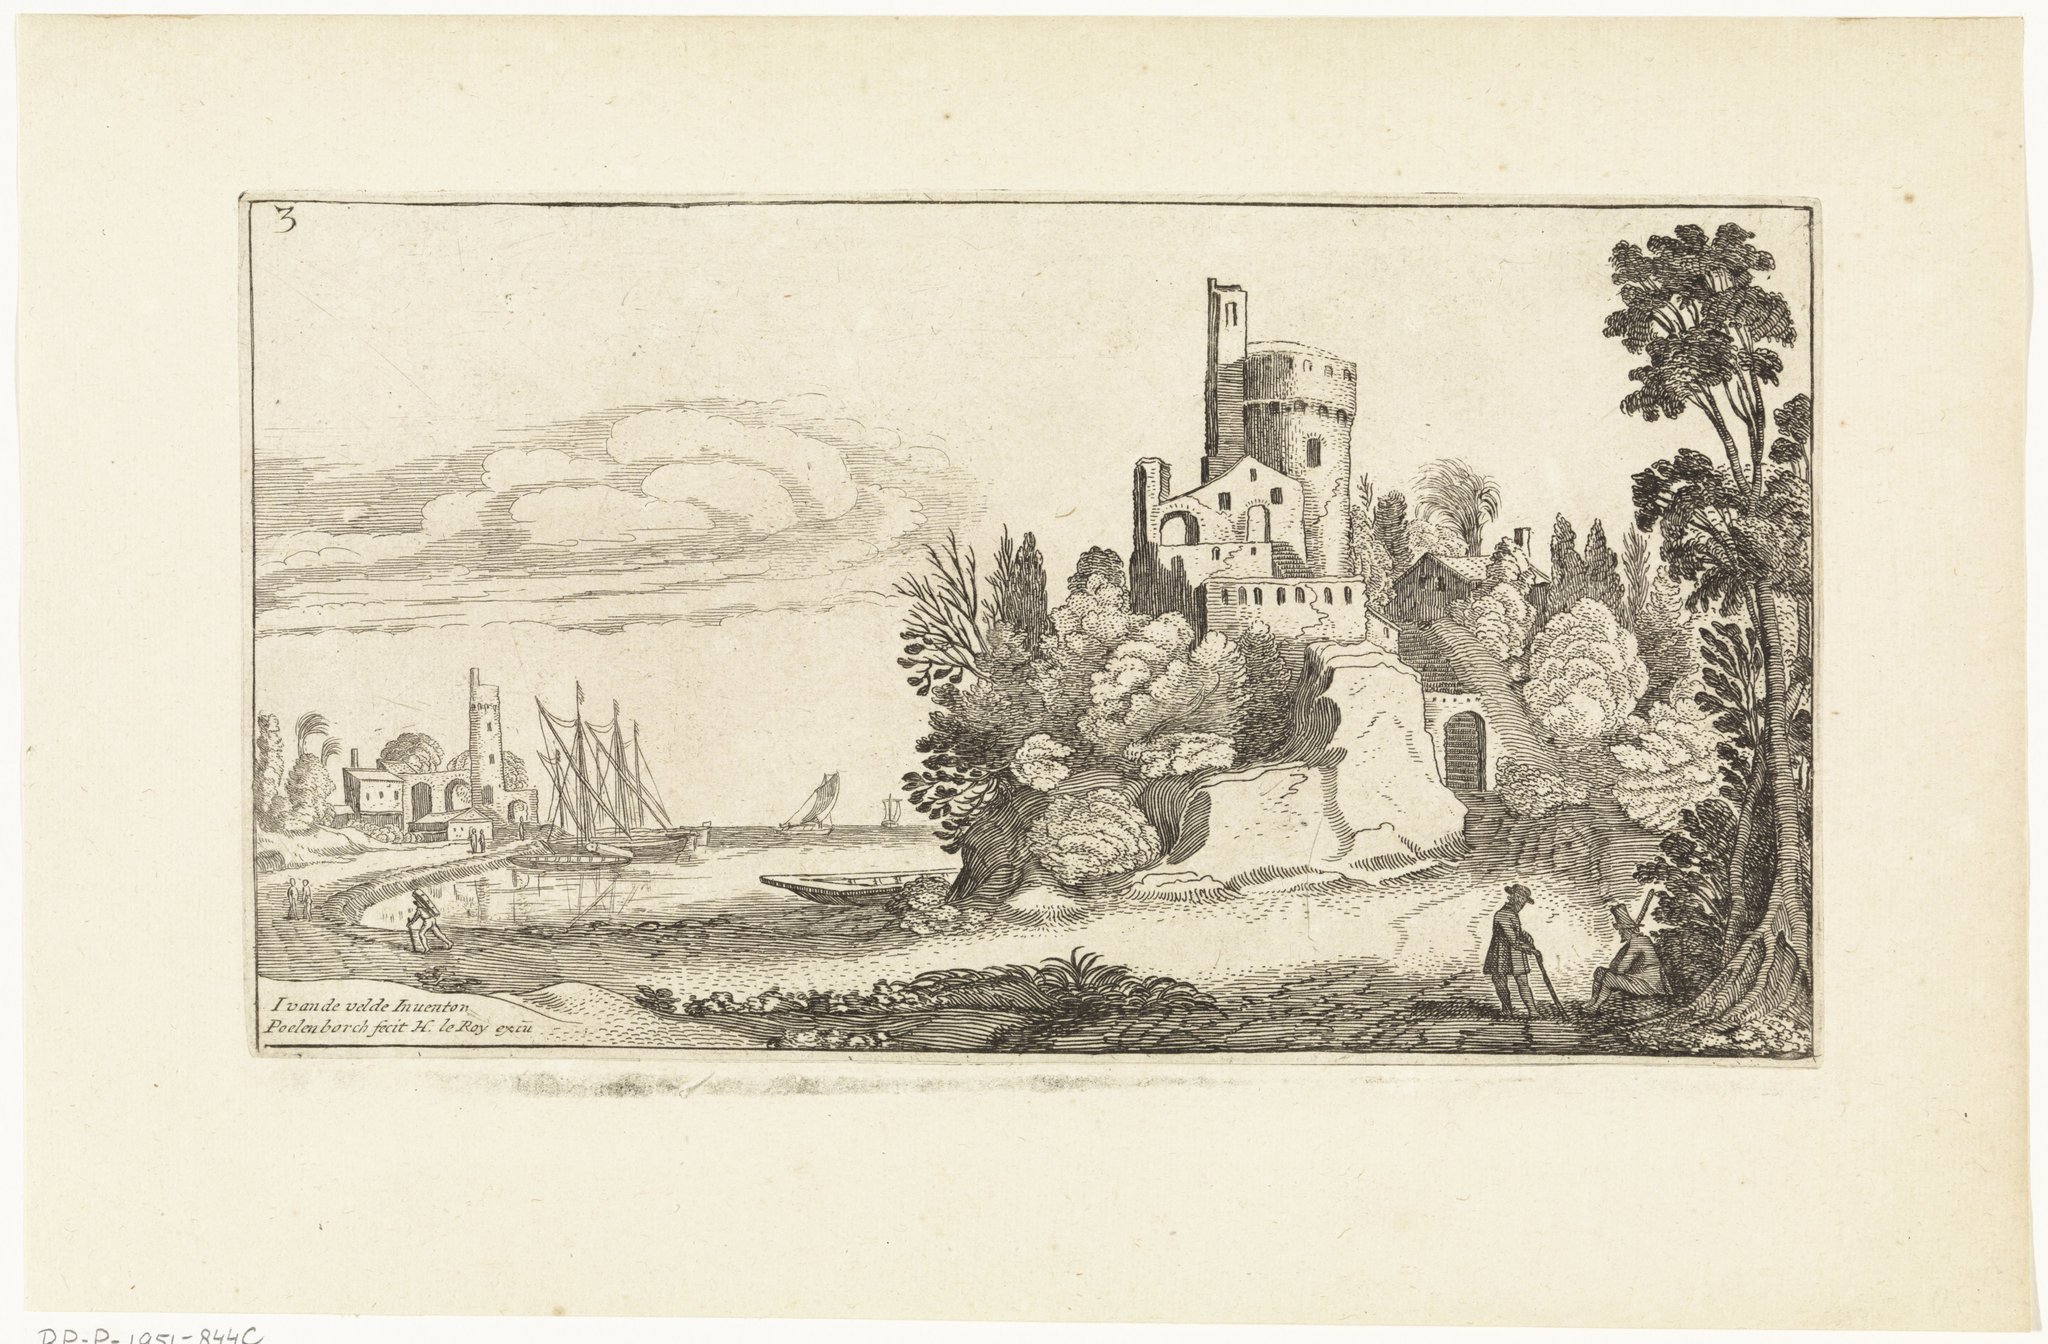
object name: print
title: Landschap met kasteel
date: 1602-1649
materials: paper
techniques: etching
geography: amsterdam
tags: landscape with tower or castle - ii - ideal landscapes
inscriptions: collector's mark: Lugt 2228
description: Aan de rand van het water bevindt zich op een hoge rots een kasteel. Op het water liggen verschillende boten. Op de achtergrond een toren met bijgebouwen. Op de voorgrond twee mannen.